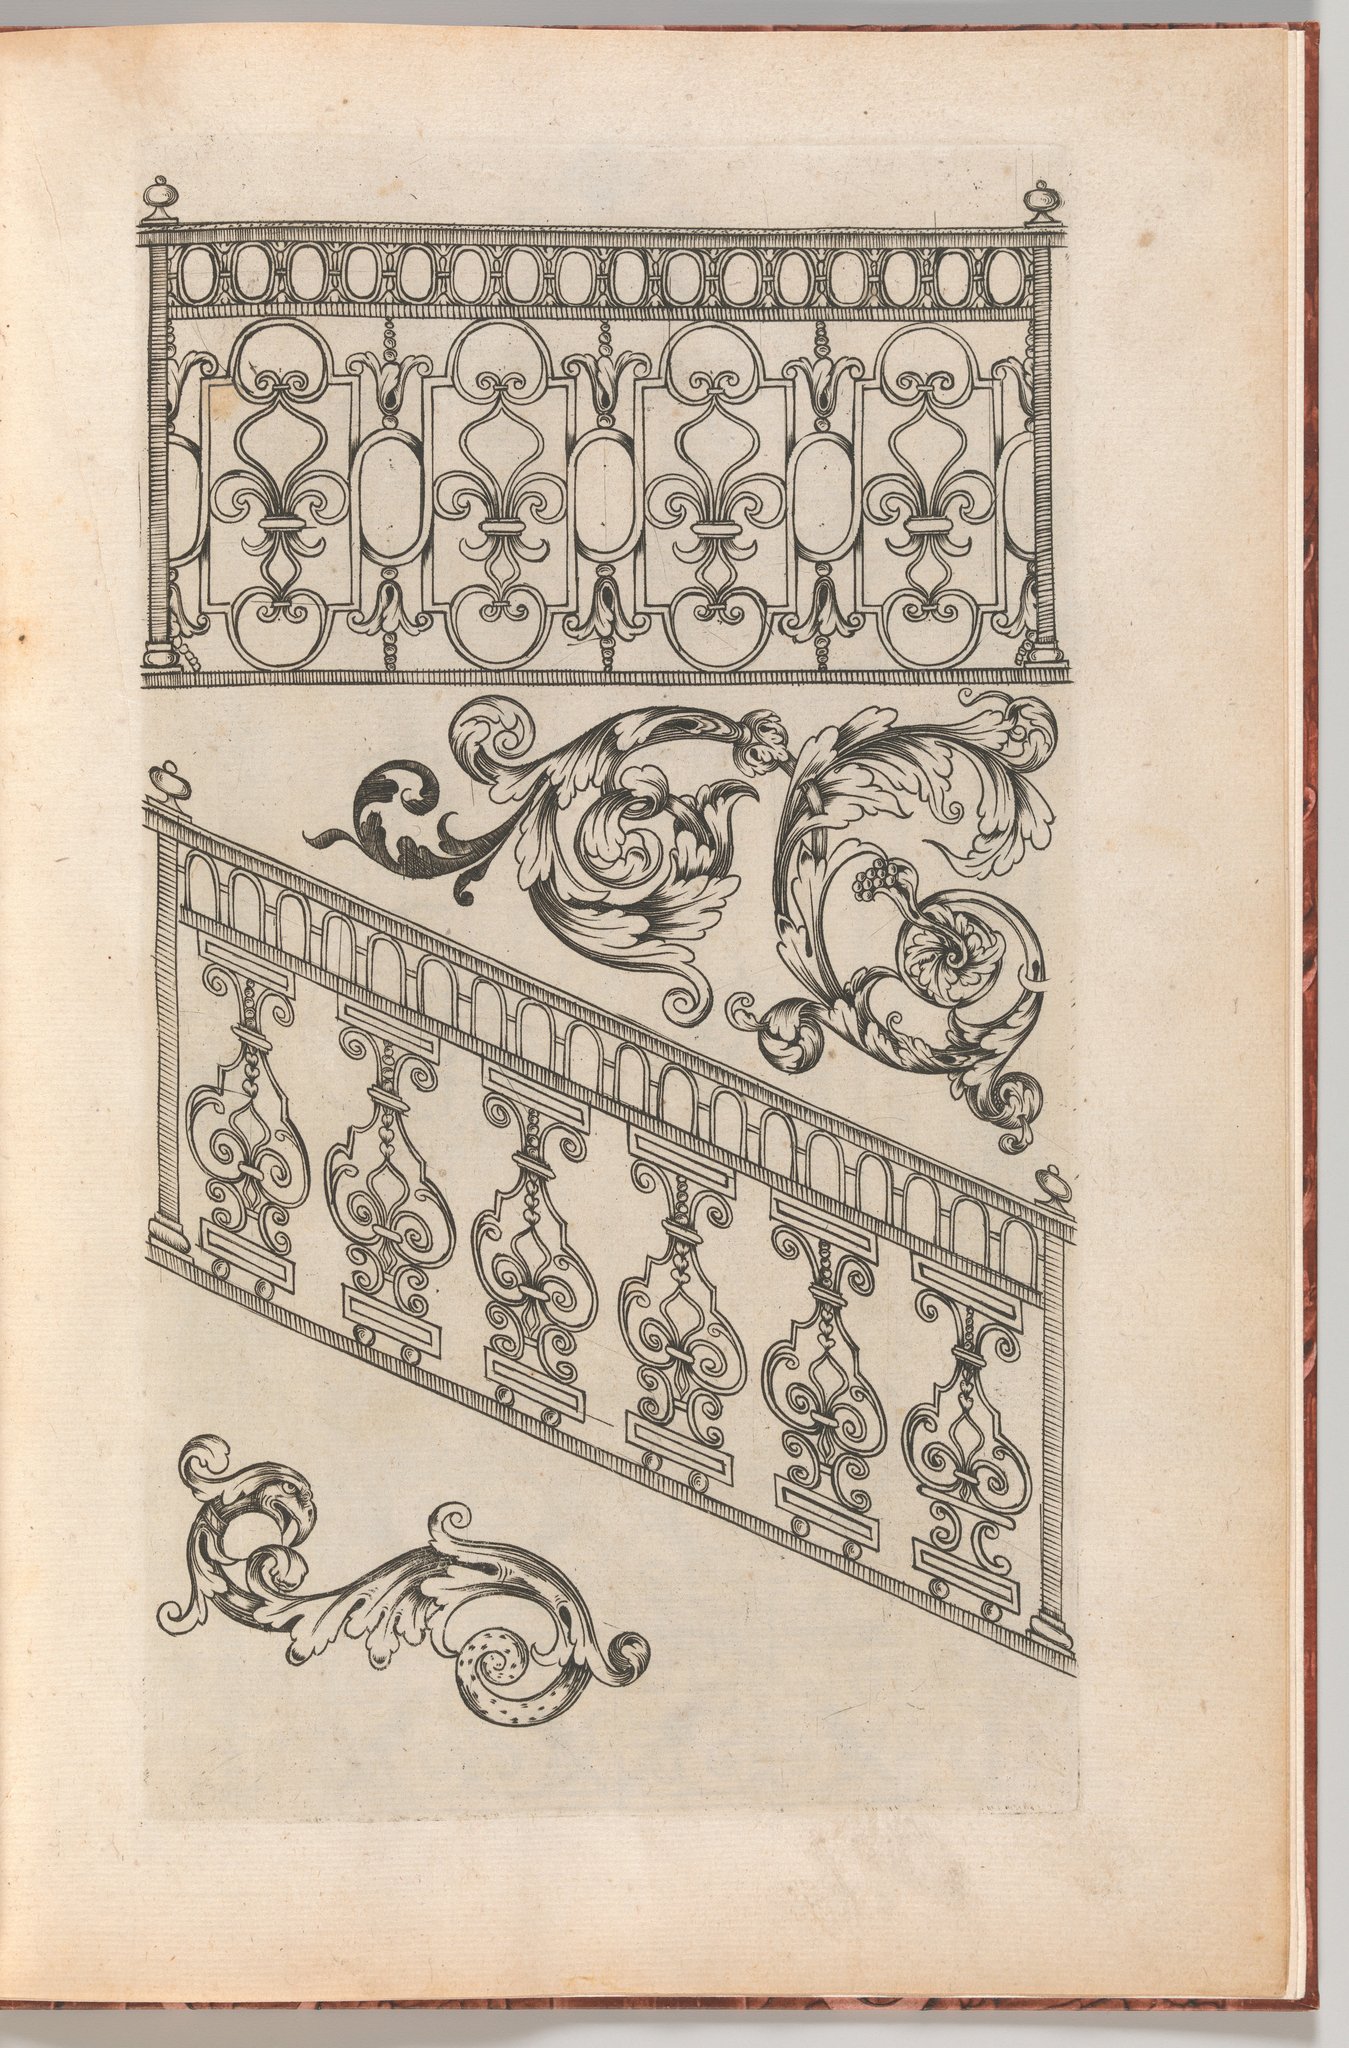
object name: album print ornament architecture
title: Diverses Pieces de Serruriers, page 16 (recto)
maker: jean berain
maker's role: artist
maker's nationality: french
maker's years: 1640-1711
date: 1663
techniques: engraving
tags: ornament,acanthus